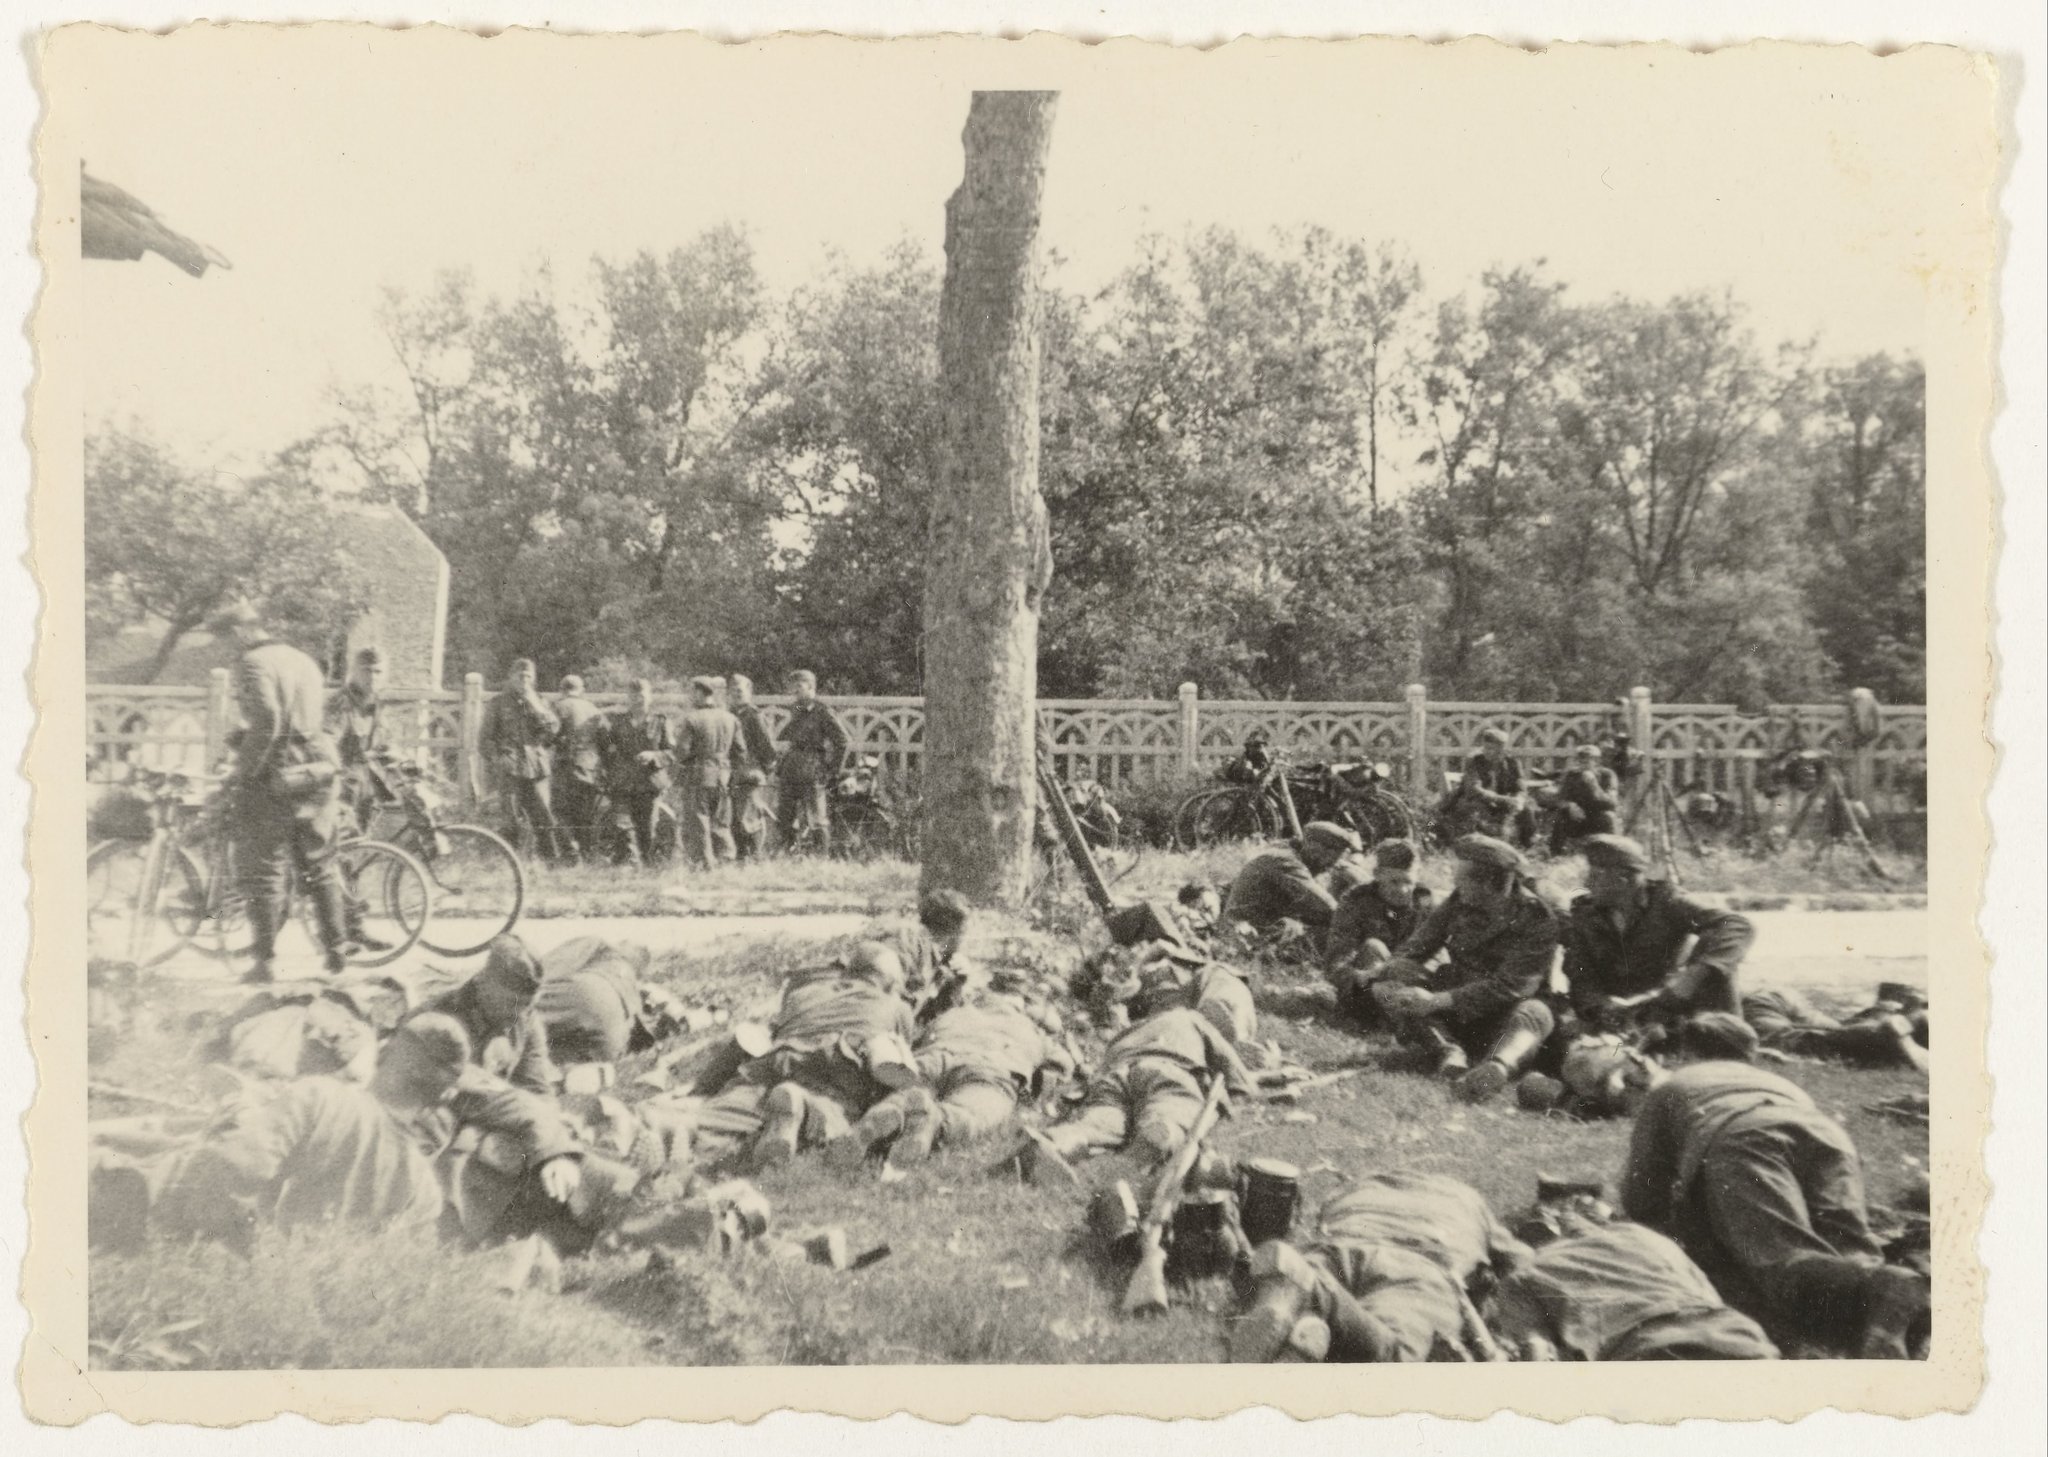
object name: photograph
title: Duitse militairen liggend in het gras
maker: Anonymous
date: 1940-1945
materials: photographic support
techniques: gelatin silver print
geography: netherlands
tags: germany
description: Een grote groep Duitse militairen ligt en zit in het gras. Achter hen een hek, een boom en twee militairen met fietsen. Foto behorend bij album 'Kriegserinnerungen'.